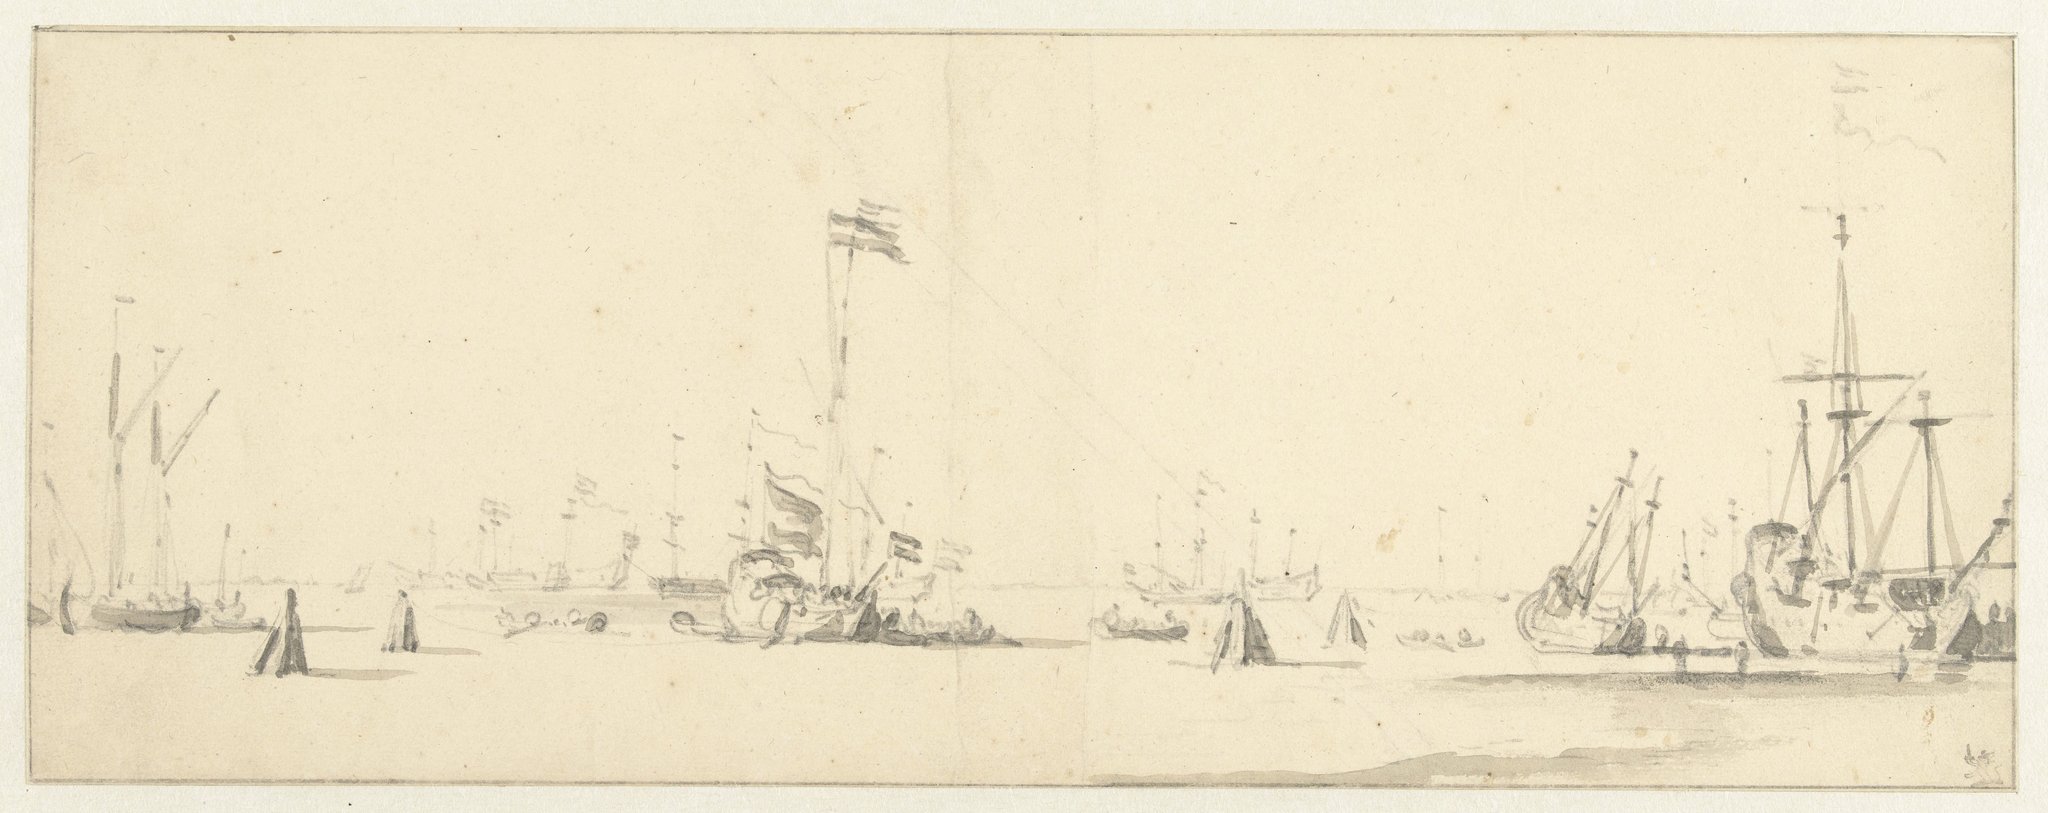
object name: drawing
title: De Hollandse vloot voor anker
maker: willem van de velde (ii)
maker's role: draughtsman, painter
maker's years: 1633-1707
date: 1643-1707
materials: paper, pencil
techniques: brush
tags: sailing-ship, sailing-boat, sea (seascape), ship in the roads, roadstead, navy (+ sailing-ships)